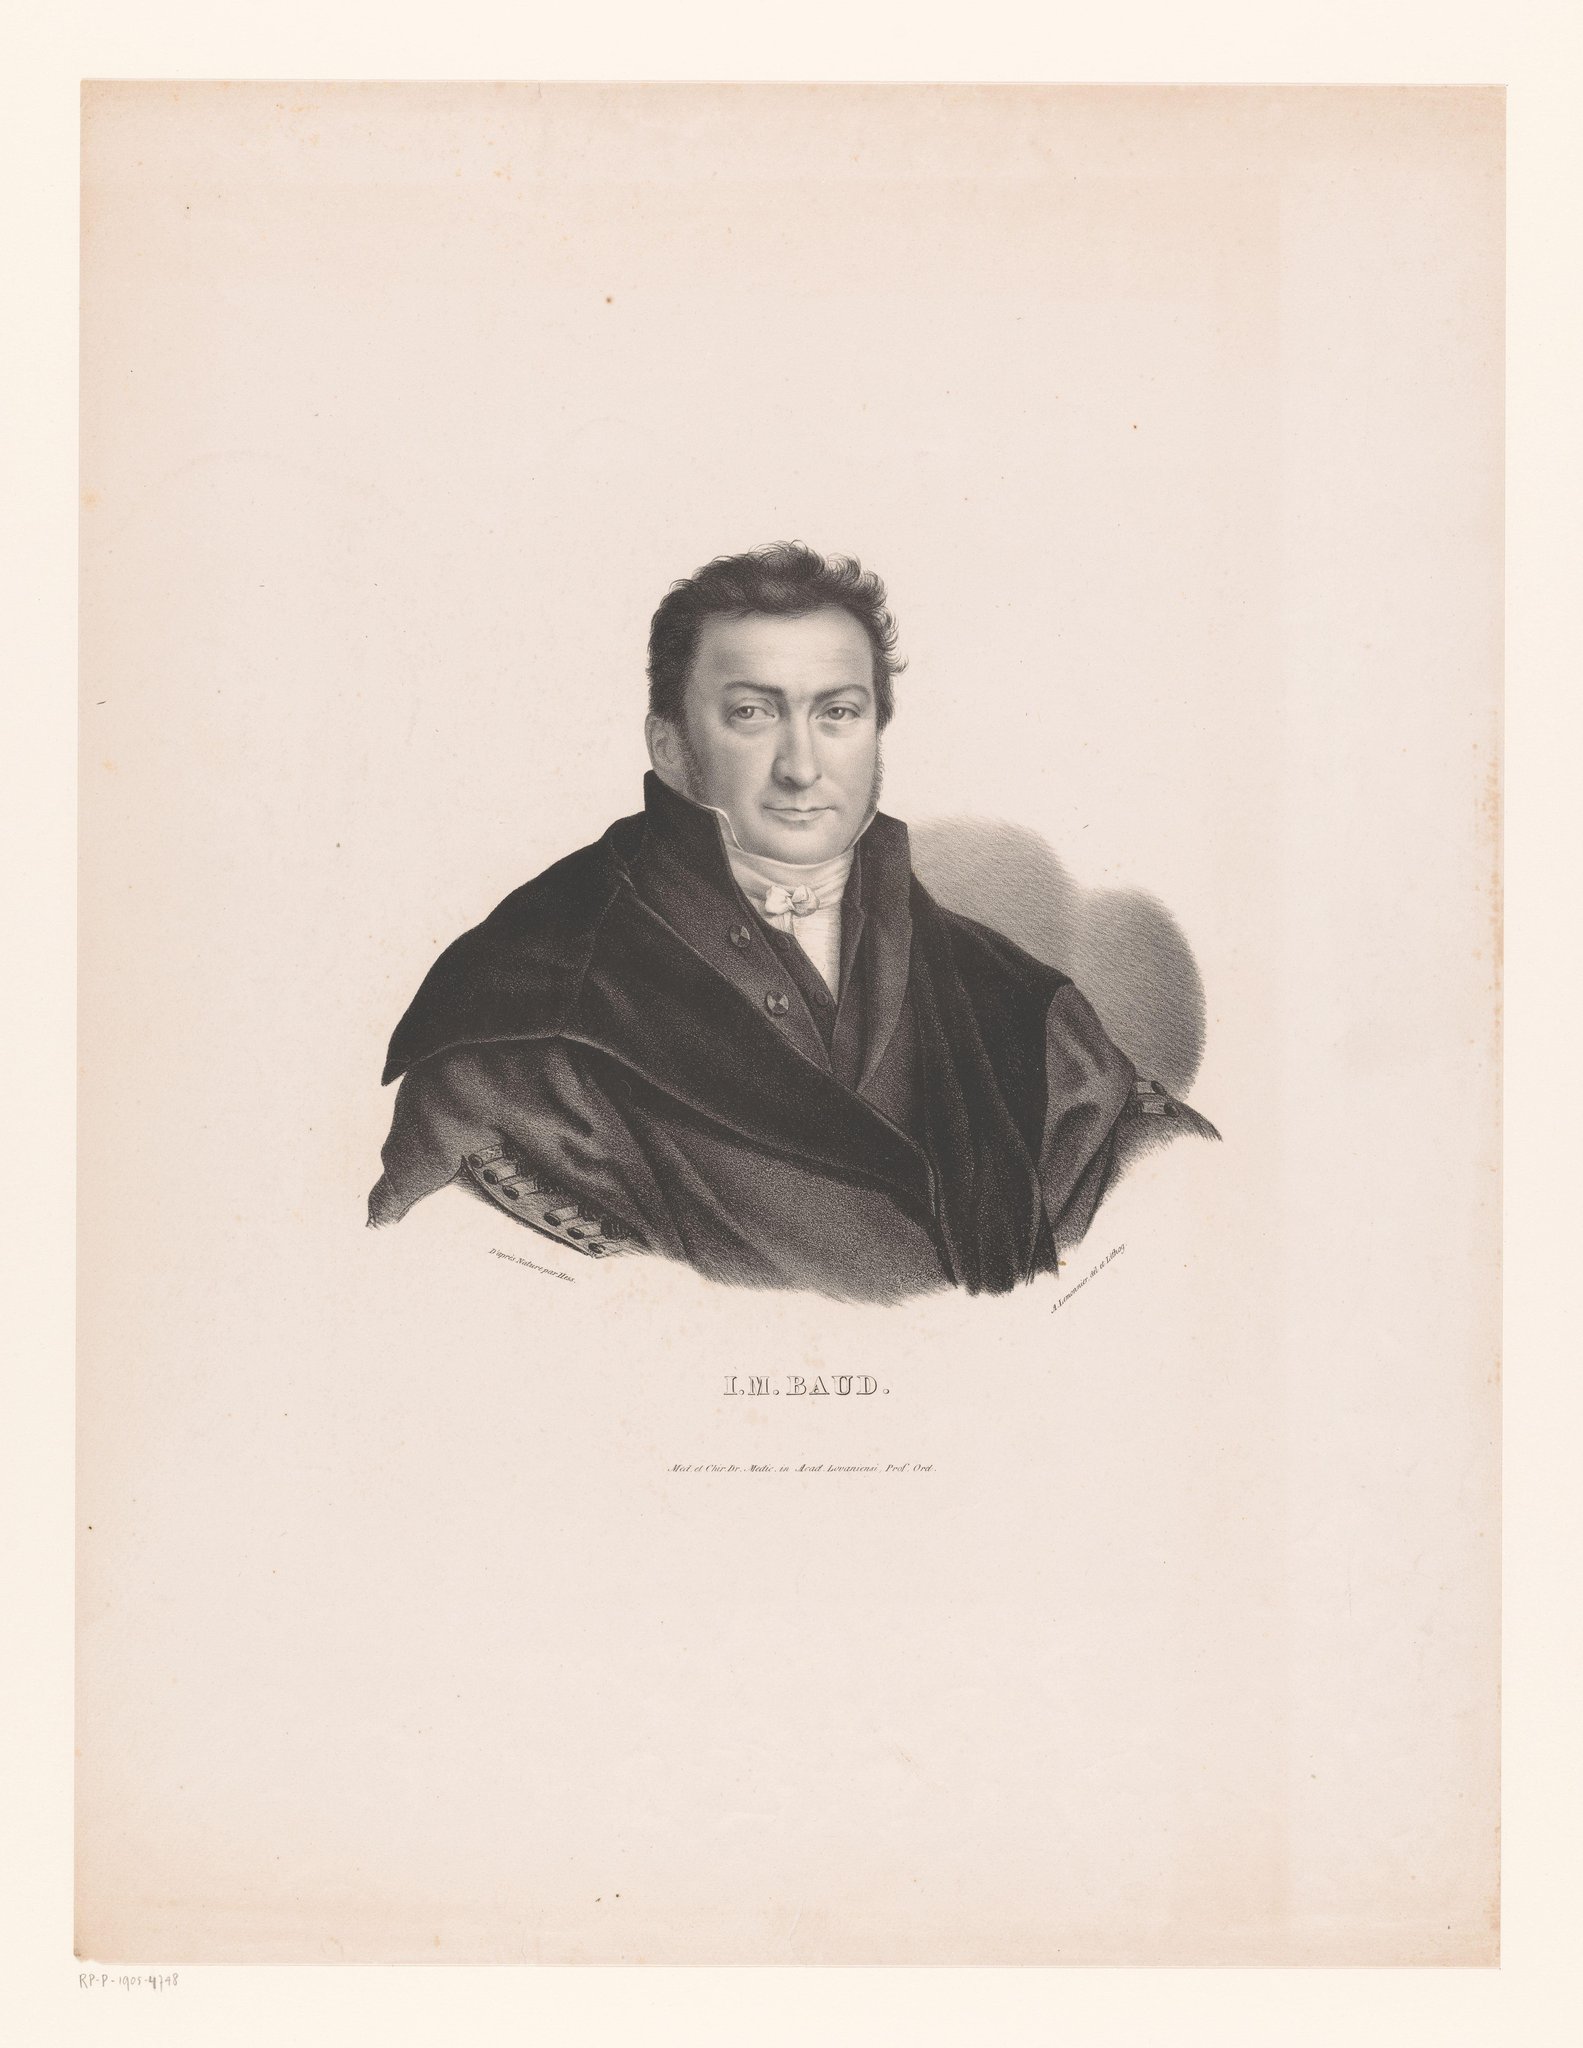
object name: print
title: I.M. Baud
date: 1827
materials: paper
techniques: lithograph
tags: historical persons, medicine, medical science (+ portrait of scholar, scientist)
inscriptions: collector's mark: Lugt 2228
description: Prent verschenen in: Hess, Marcel. Iconographie des professeurs des universites des Pays-Bas. Brussel: Van Someren, 1827.